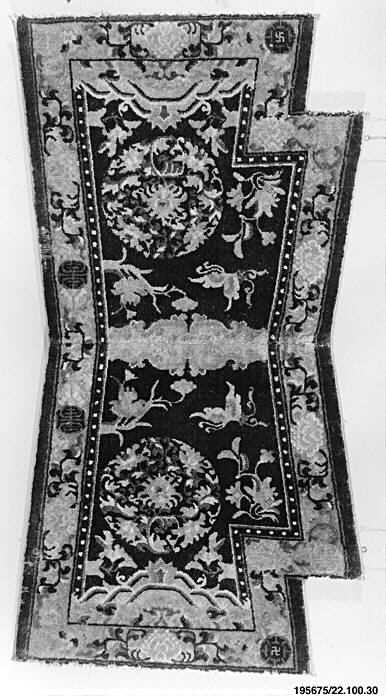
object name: rug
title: Saddle Rug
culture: chinese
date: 1801-1900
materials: cotton, hair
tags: flowers